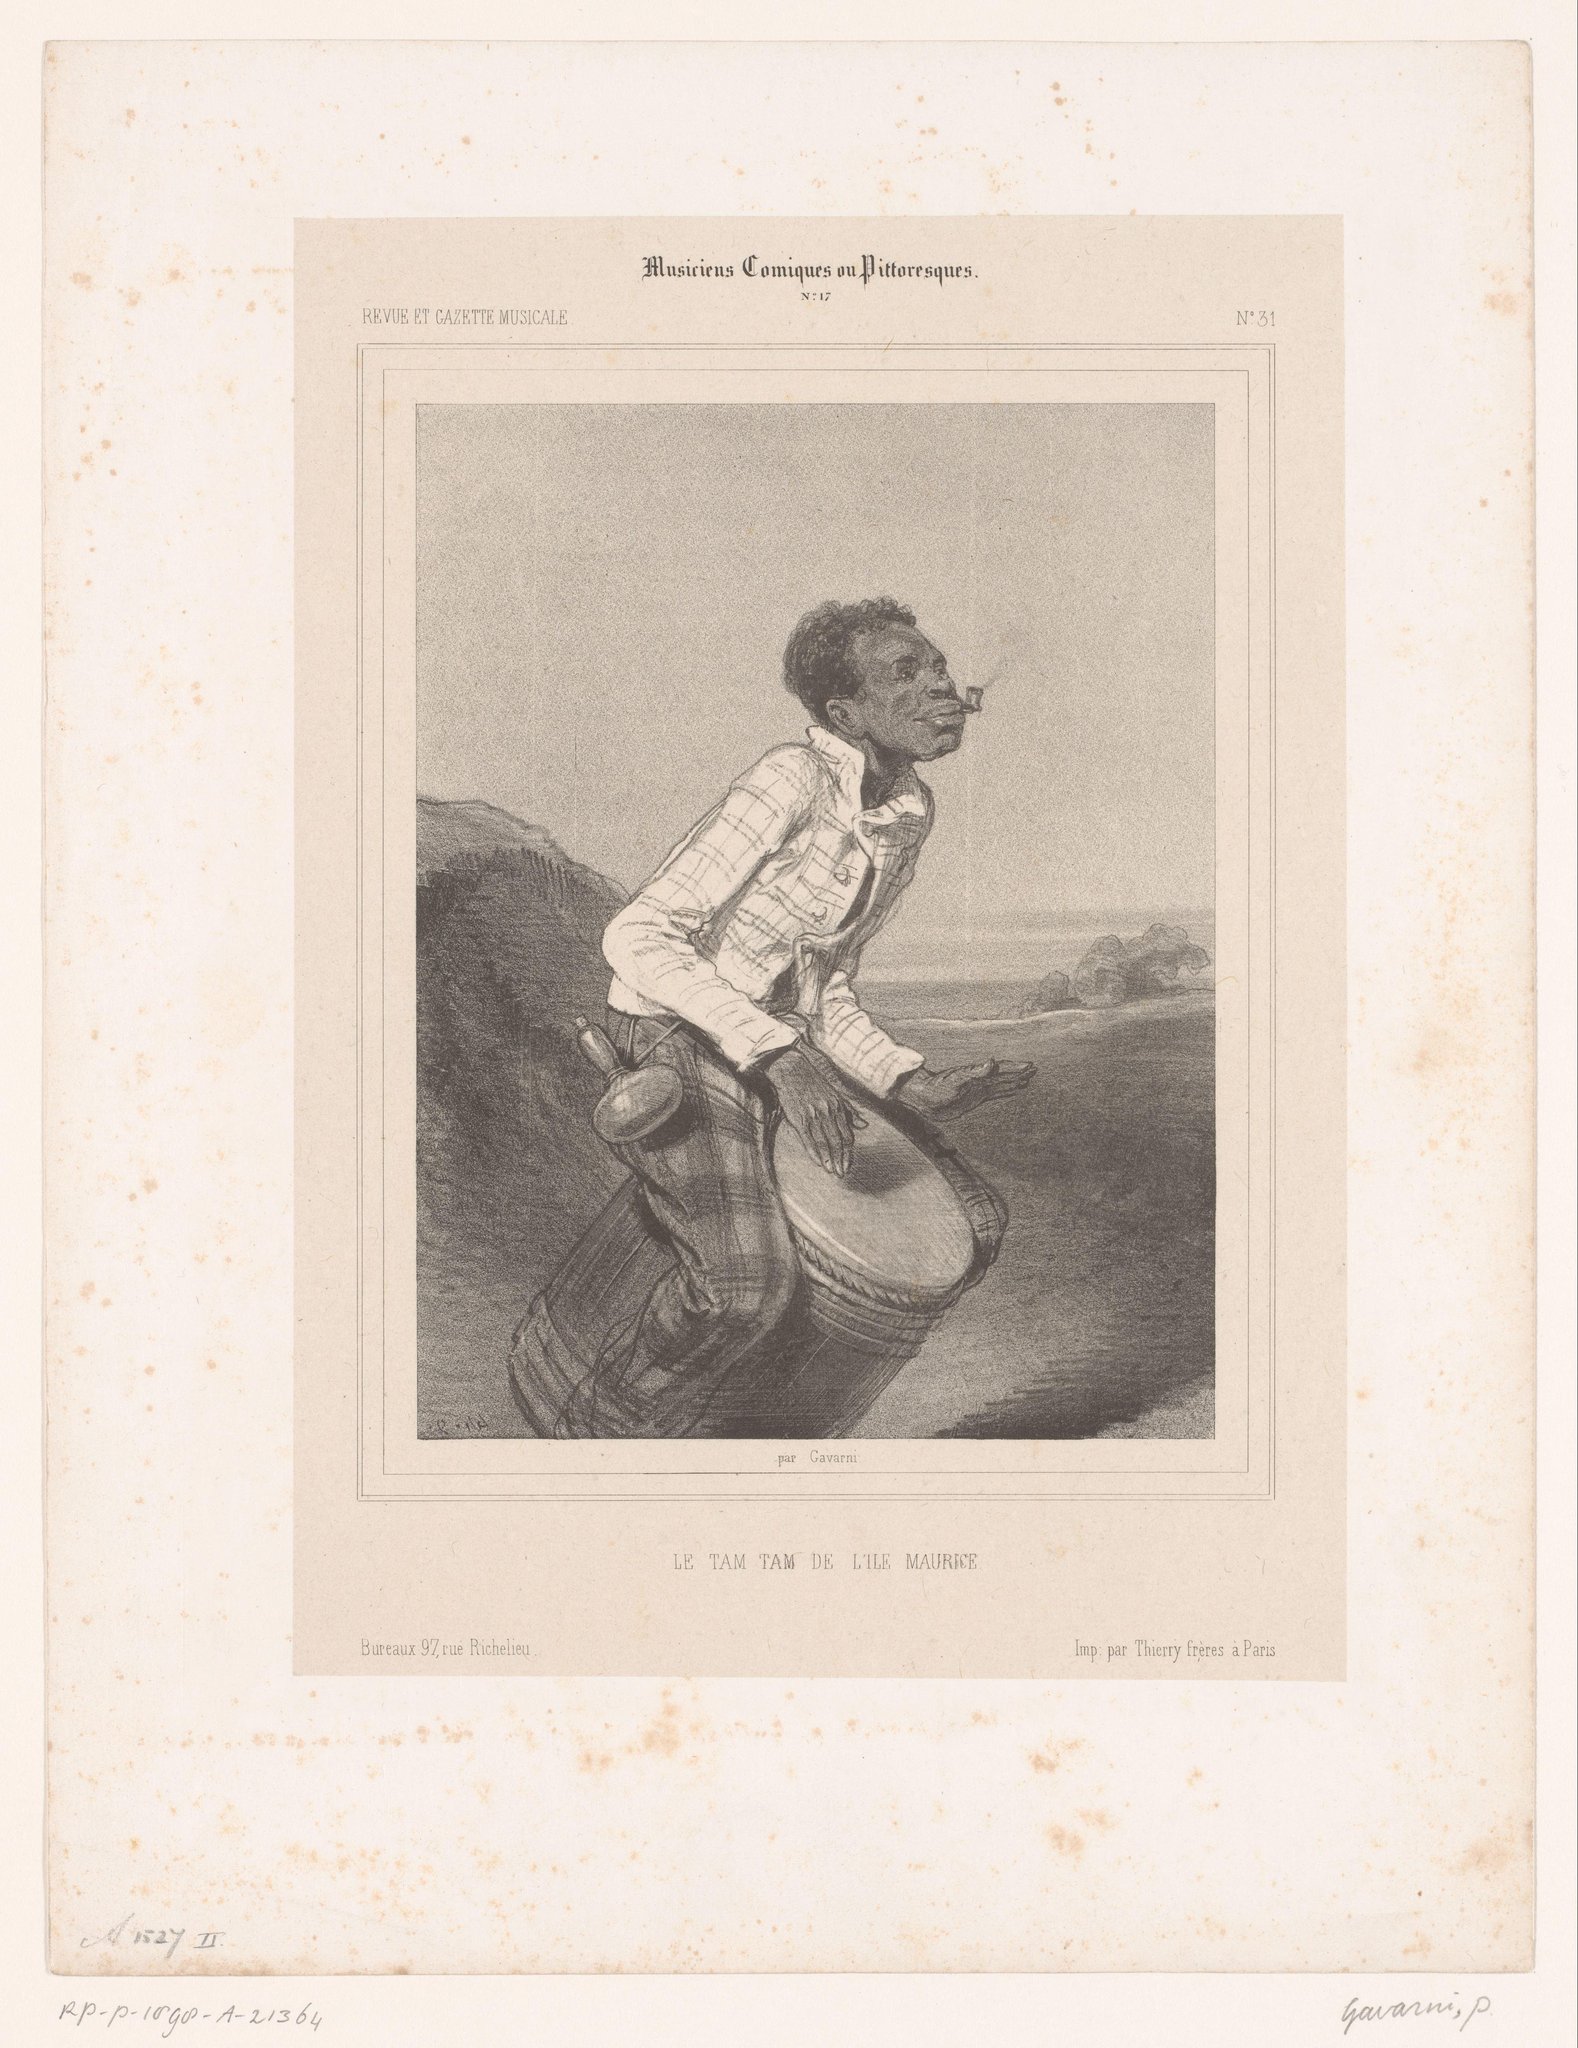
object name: print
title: Le tam-tam de l'île Maurice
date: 1844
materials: paper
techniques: lithograph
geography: paris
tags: musician at work - cc - out of doors, africans, drum (musical instrument) - cc - out of doors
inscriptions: collector's mark: Lugt 964